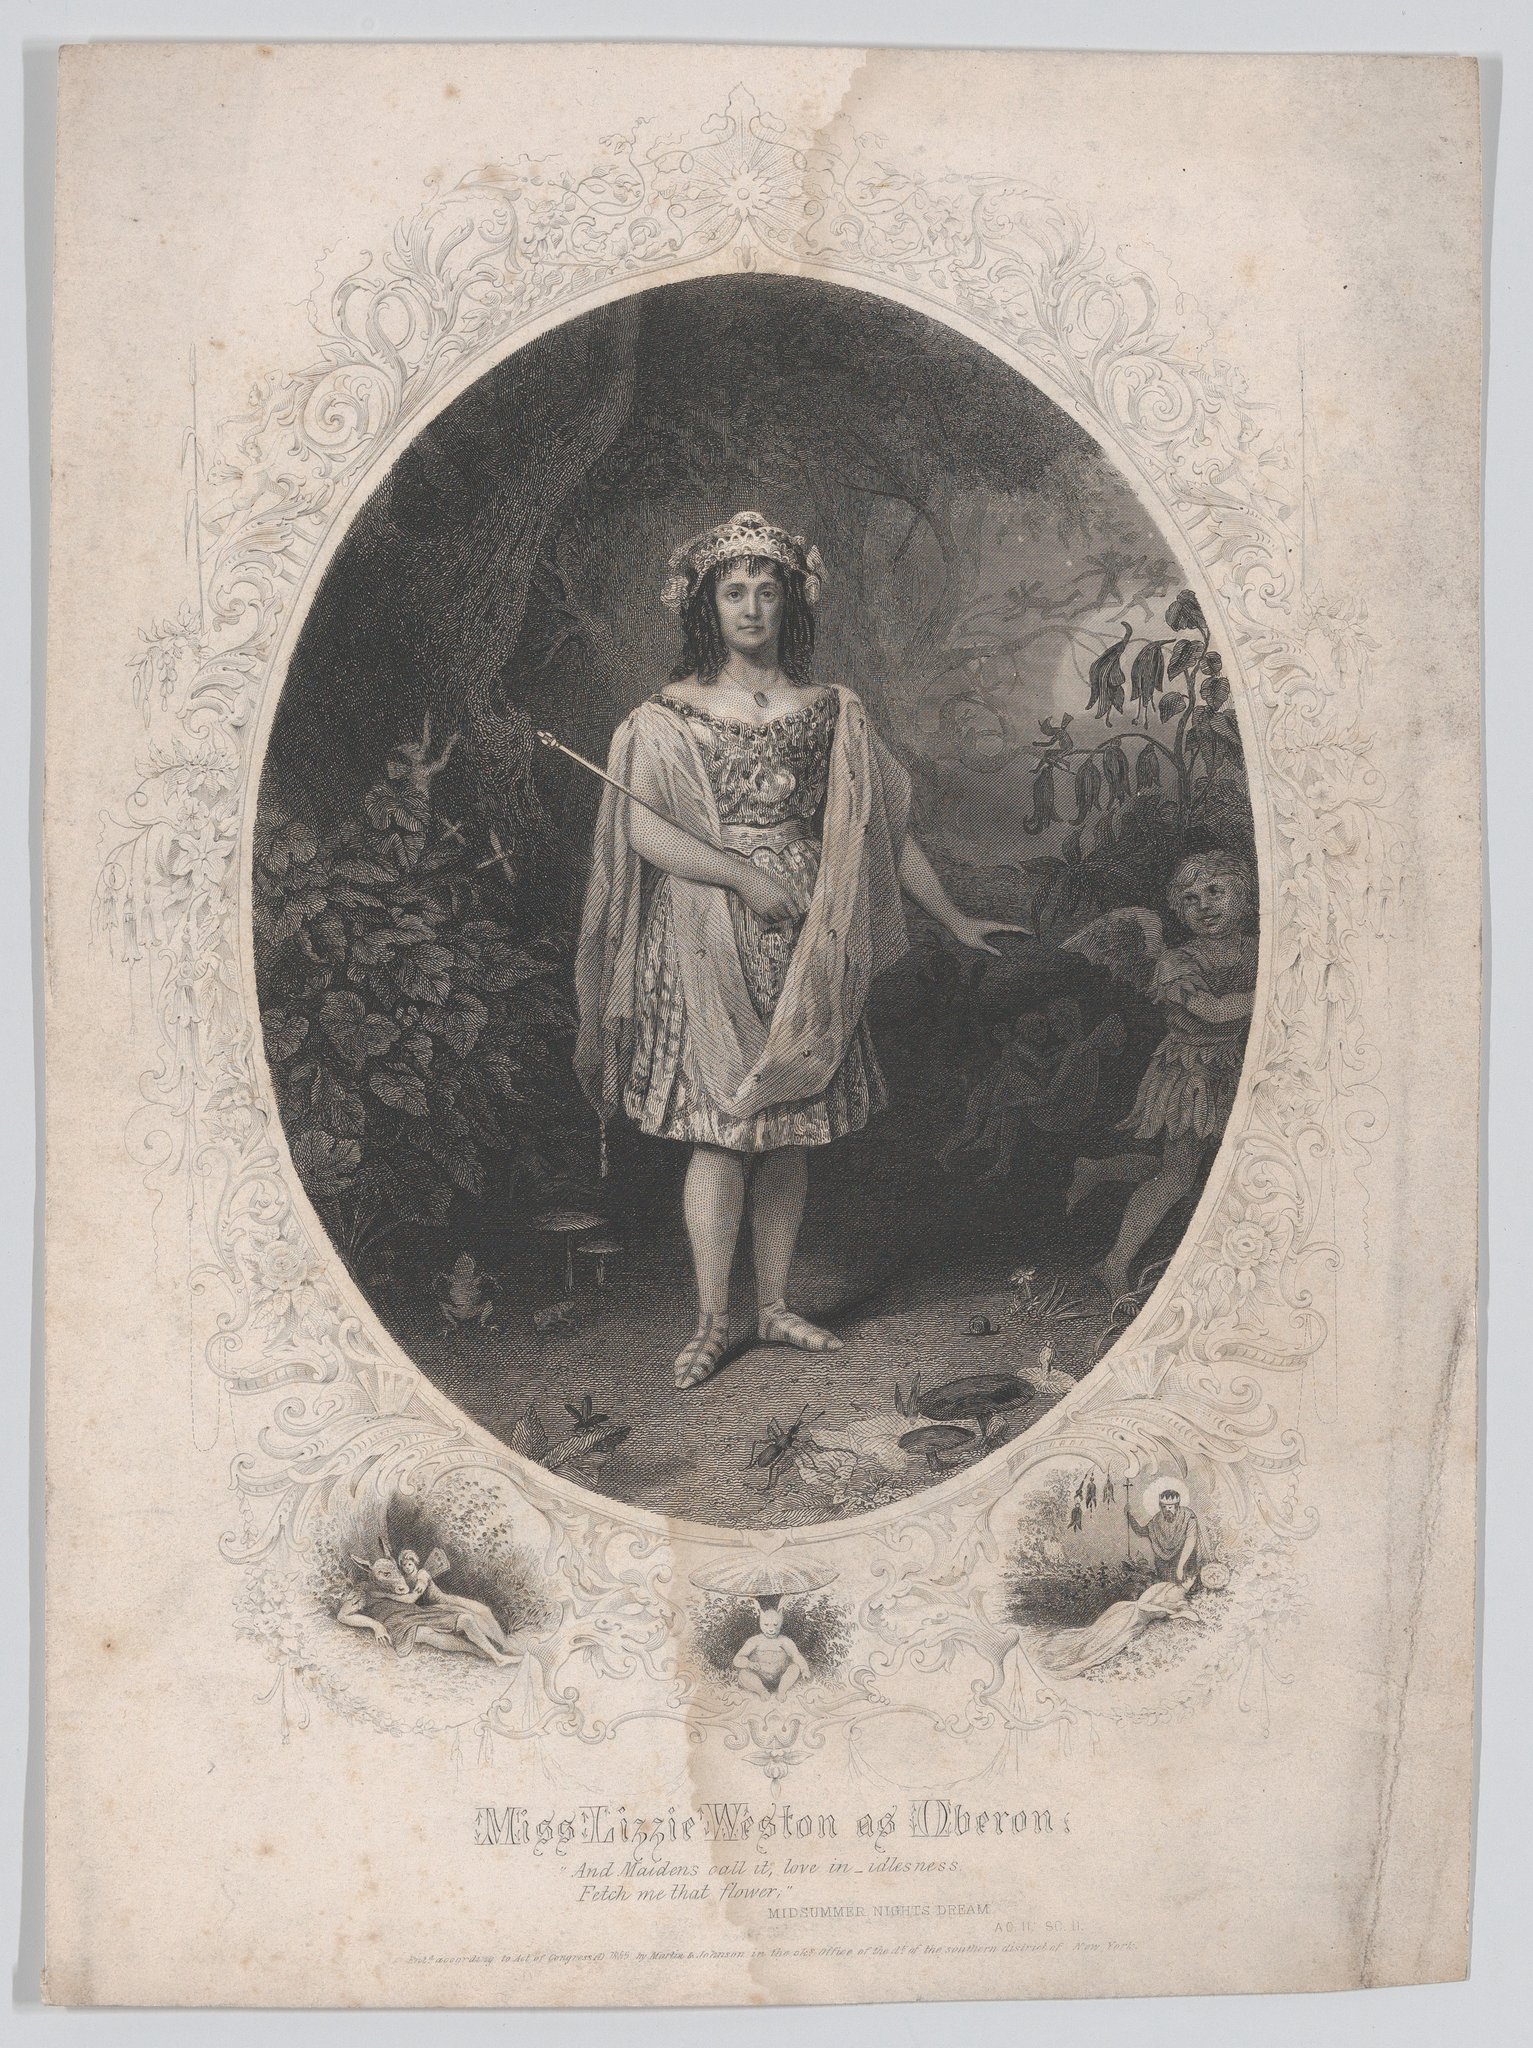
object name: print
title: Miss Lizzie Weston as Oberon: "And Maidens call it, love in idleness. Fetch me that flower" (Midsummer Night's Dream, Act 2, Scene 2)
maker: martin & johnson, new york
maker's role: publisher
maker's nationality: american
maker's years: 1840-1860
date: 1855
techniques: engraving, stippling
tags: shakespeare,women,actresses